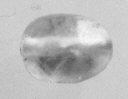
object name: stamp seal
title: Scaraboid seal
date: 1700-1560 BCE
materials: quartz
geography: levant